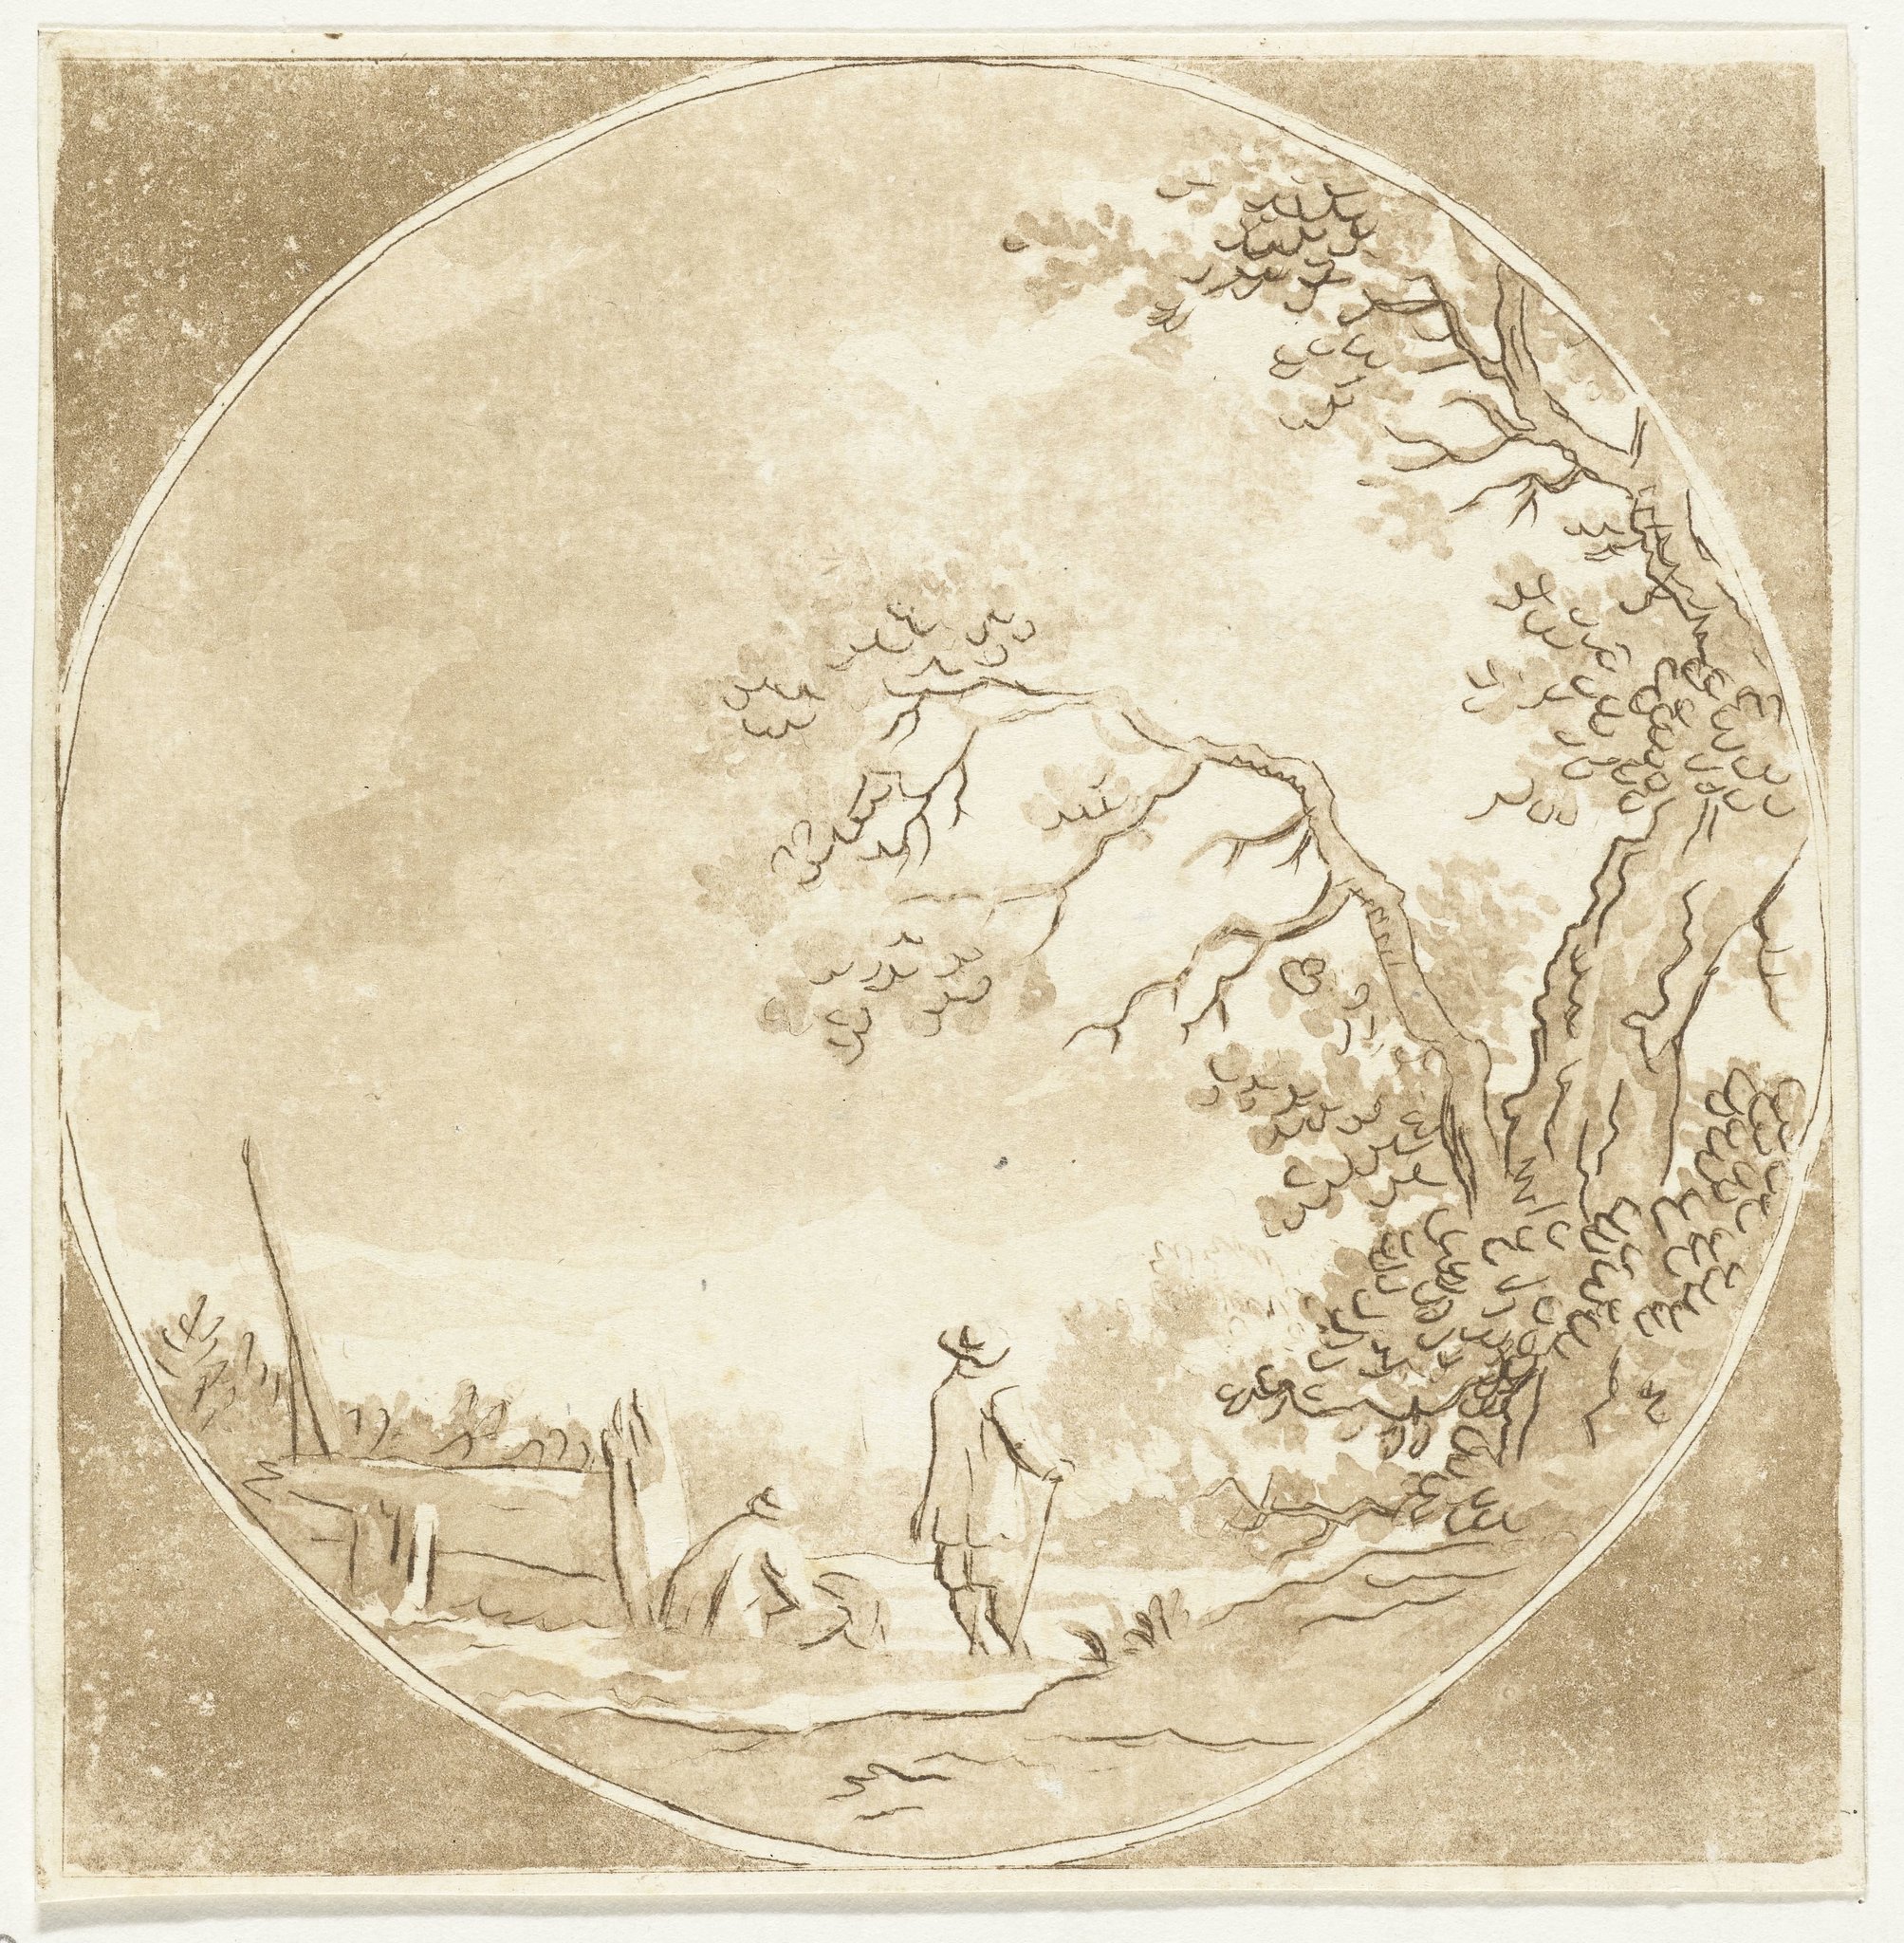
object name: print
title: Landschap met twee wandelaars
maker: anthonie van den bos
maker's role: draughtsman, print maker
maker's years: 1763-1838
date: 1778-1838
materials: paper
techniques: printing, printmaking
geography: netherlands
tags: landscapes in the temperate zone (+ landscape with figures, staffage)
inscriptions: collector's mark: Lugt 2228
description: Twee wandelaars kijken uit over een weiland naar een dorp in de verte. De een staat op zijn stok geleund de ander zit op de grond.